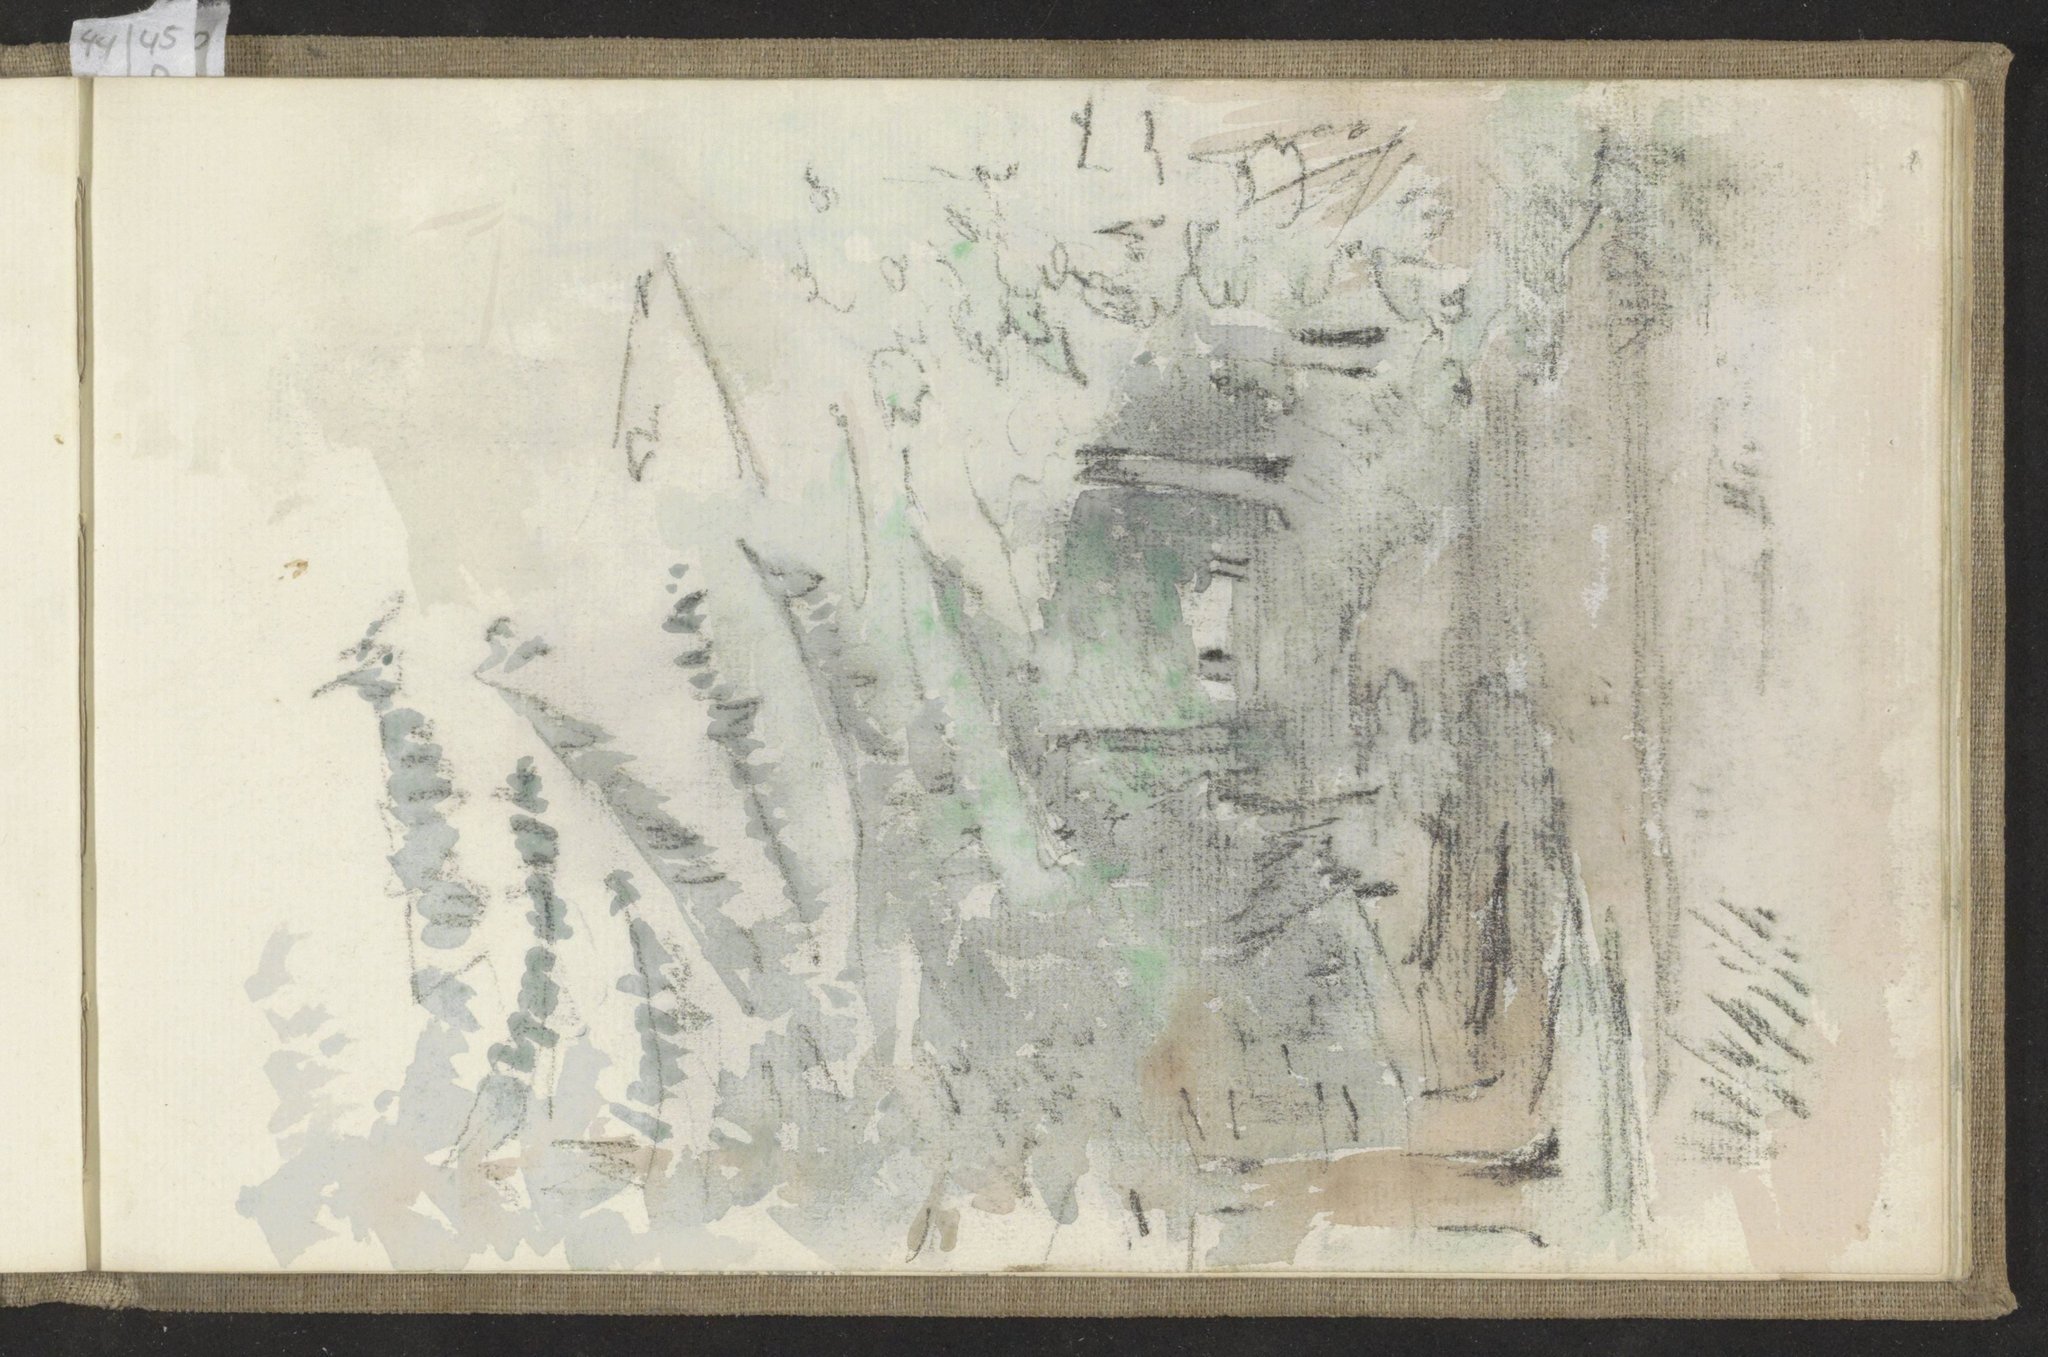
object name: sketchbook leaf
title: Bospad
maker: jonkheer johannes ludovicus paulus bosch van drakestein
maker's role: draughtsman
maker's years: 1865-1929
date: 1896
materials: paper, pencil, watercolor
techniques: brush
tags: forest path or lane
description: Blad 41 recto uit een schetsboek met 58 bladen.